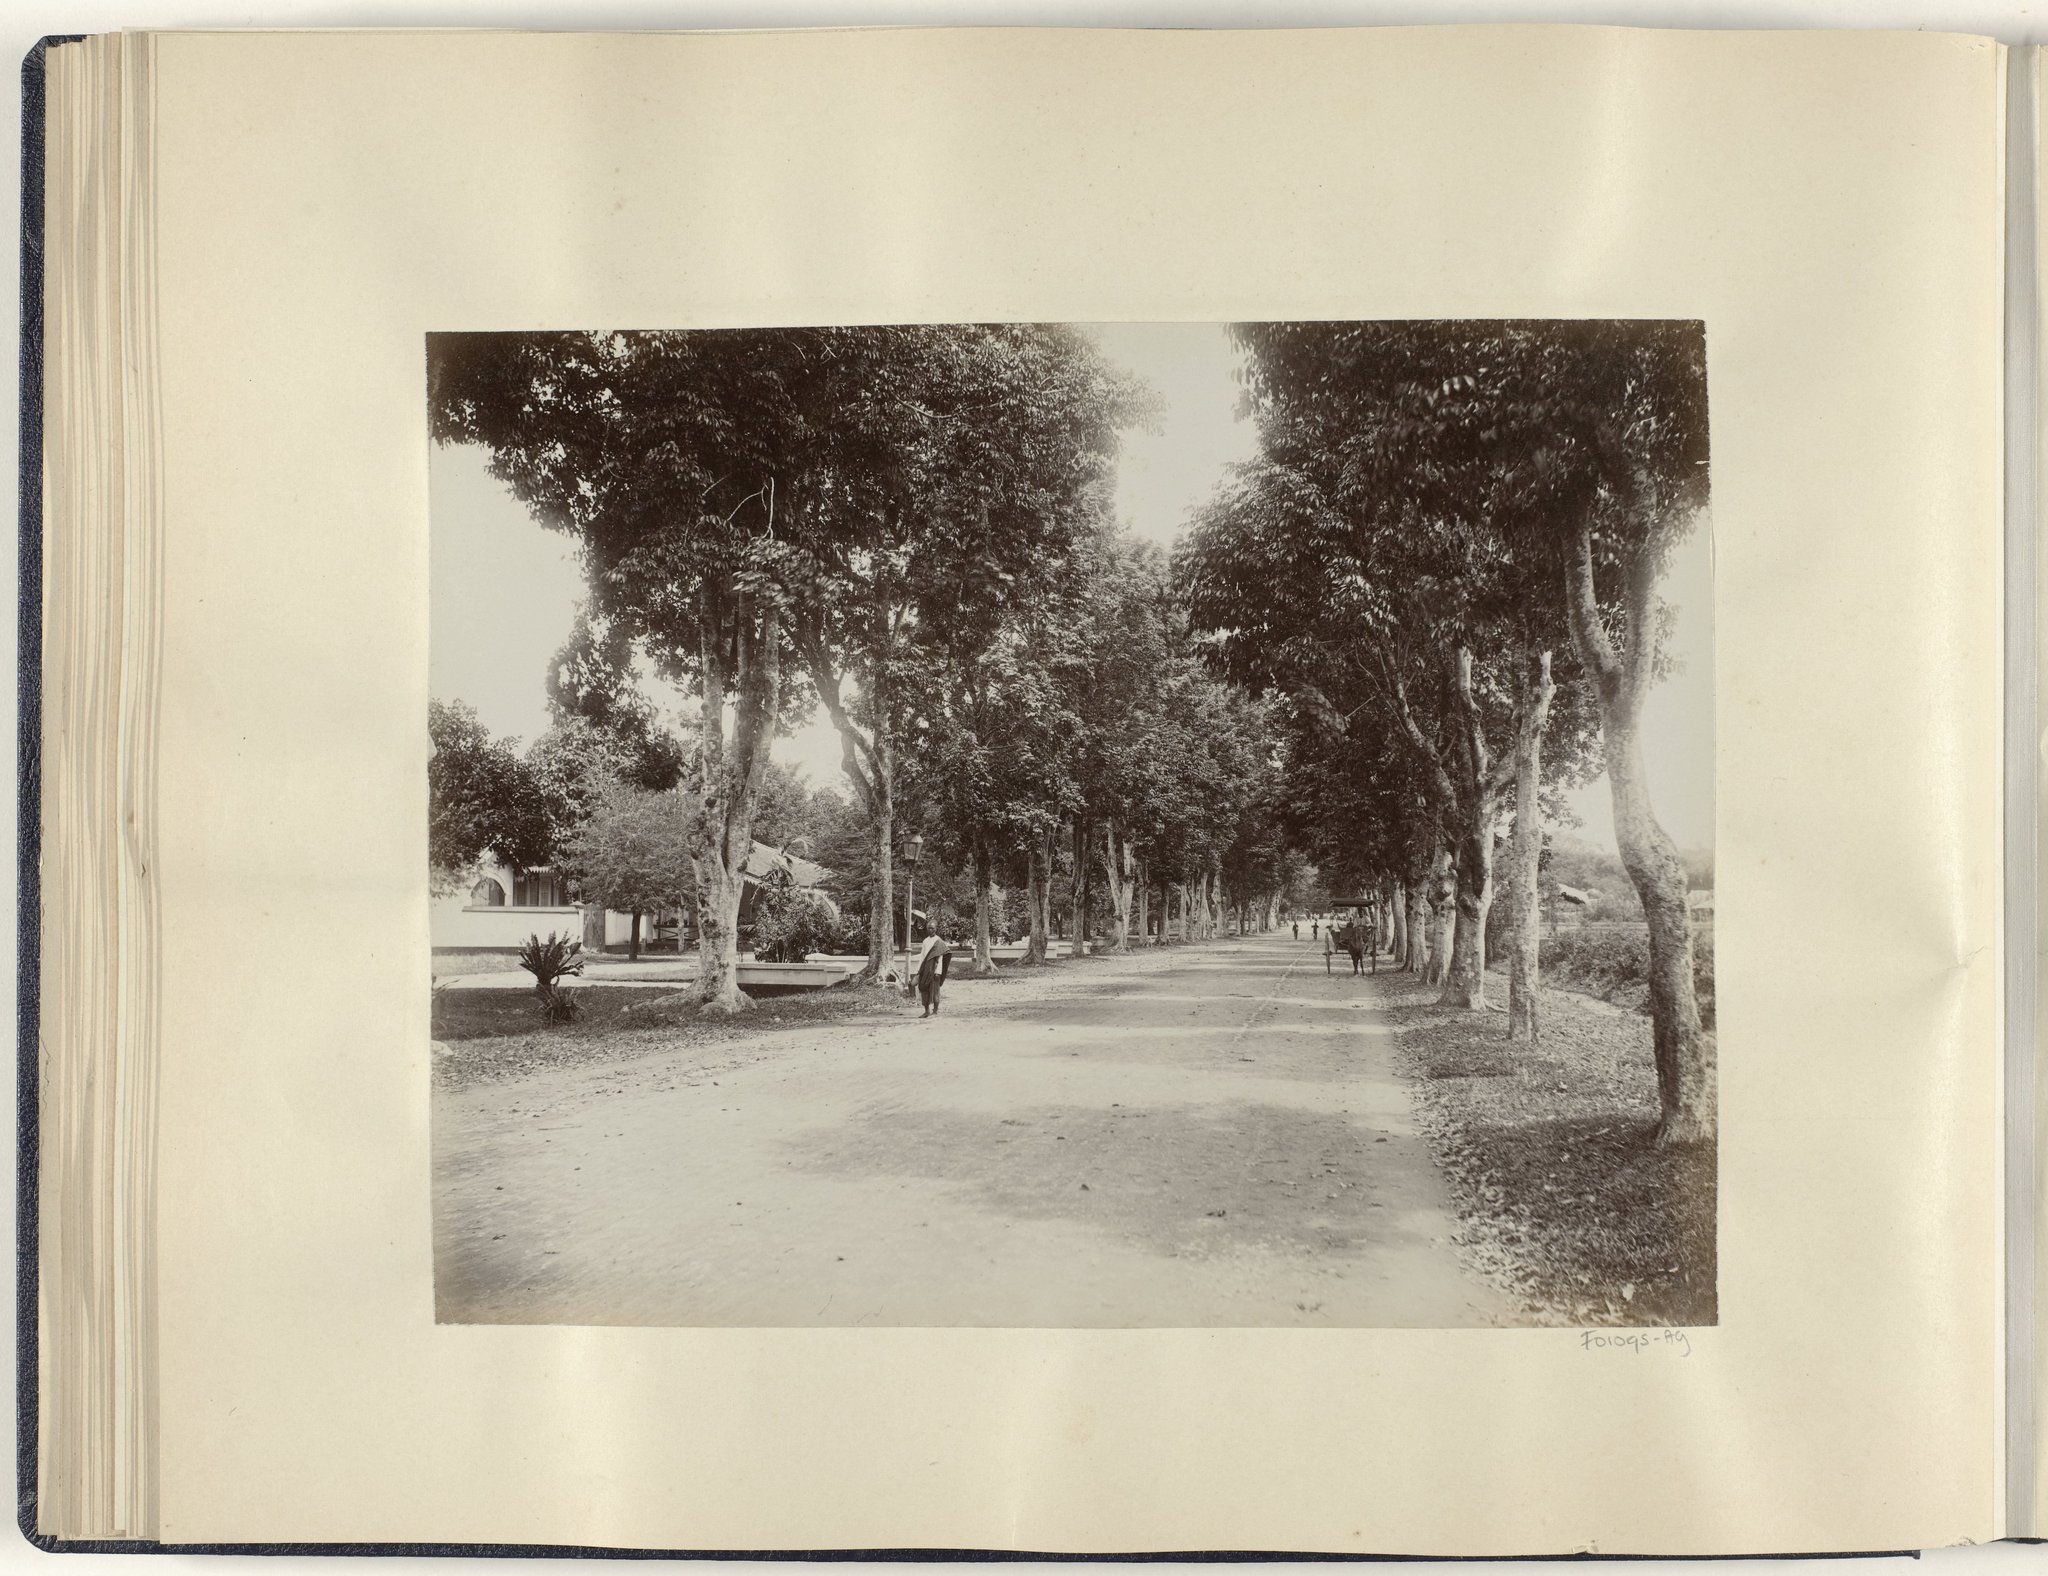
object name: photograph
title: Laan met voorbijgangers en een rijtuig, mogelijk op Sumatra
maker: Anonymous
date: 1895-1905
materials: paper, photographic support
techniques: albumen print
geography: sumatra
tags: two-wheeled, animal-drawn vehicle, forest path or lane, sumatra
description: Onderdeel van Reisalbum met foto's van bezienswaardigheden in Italië, Zwitserland en Nederlands-Indië.